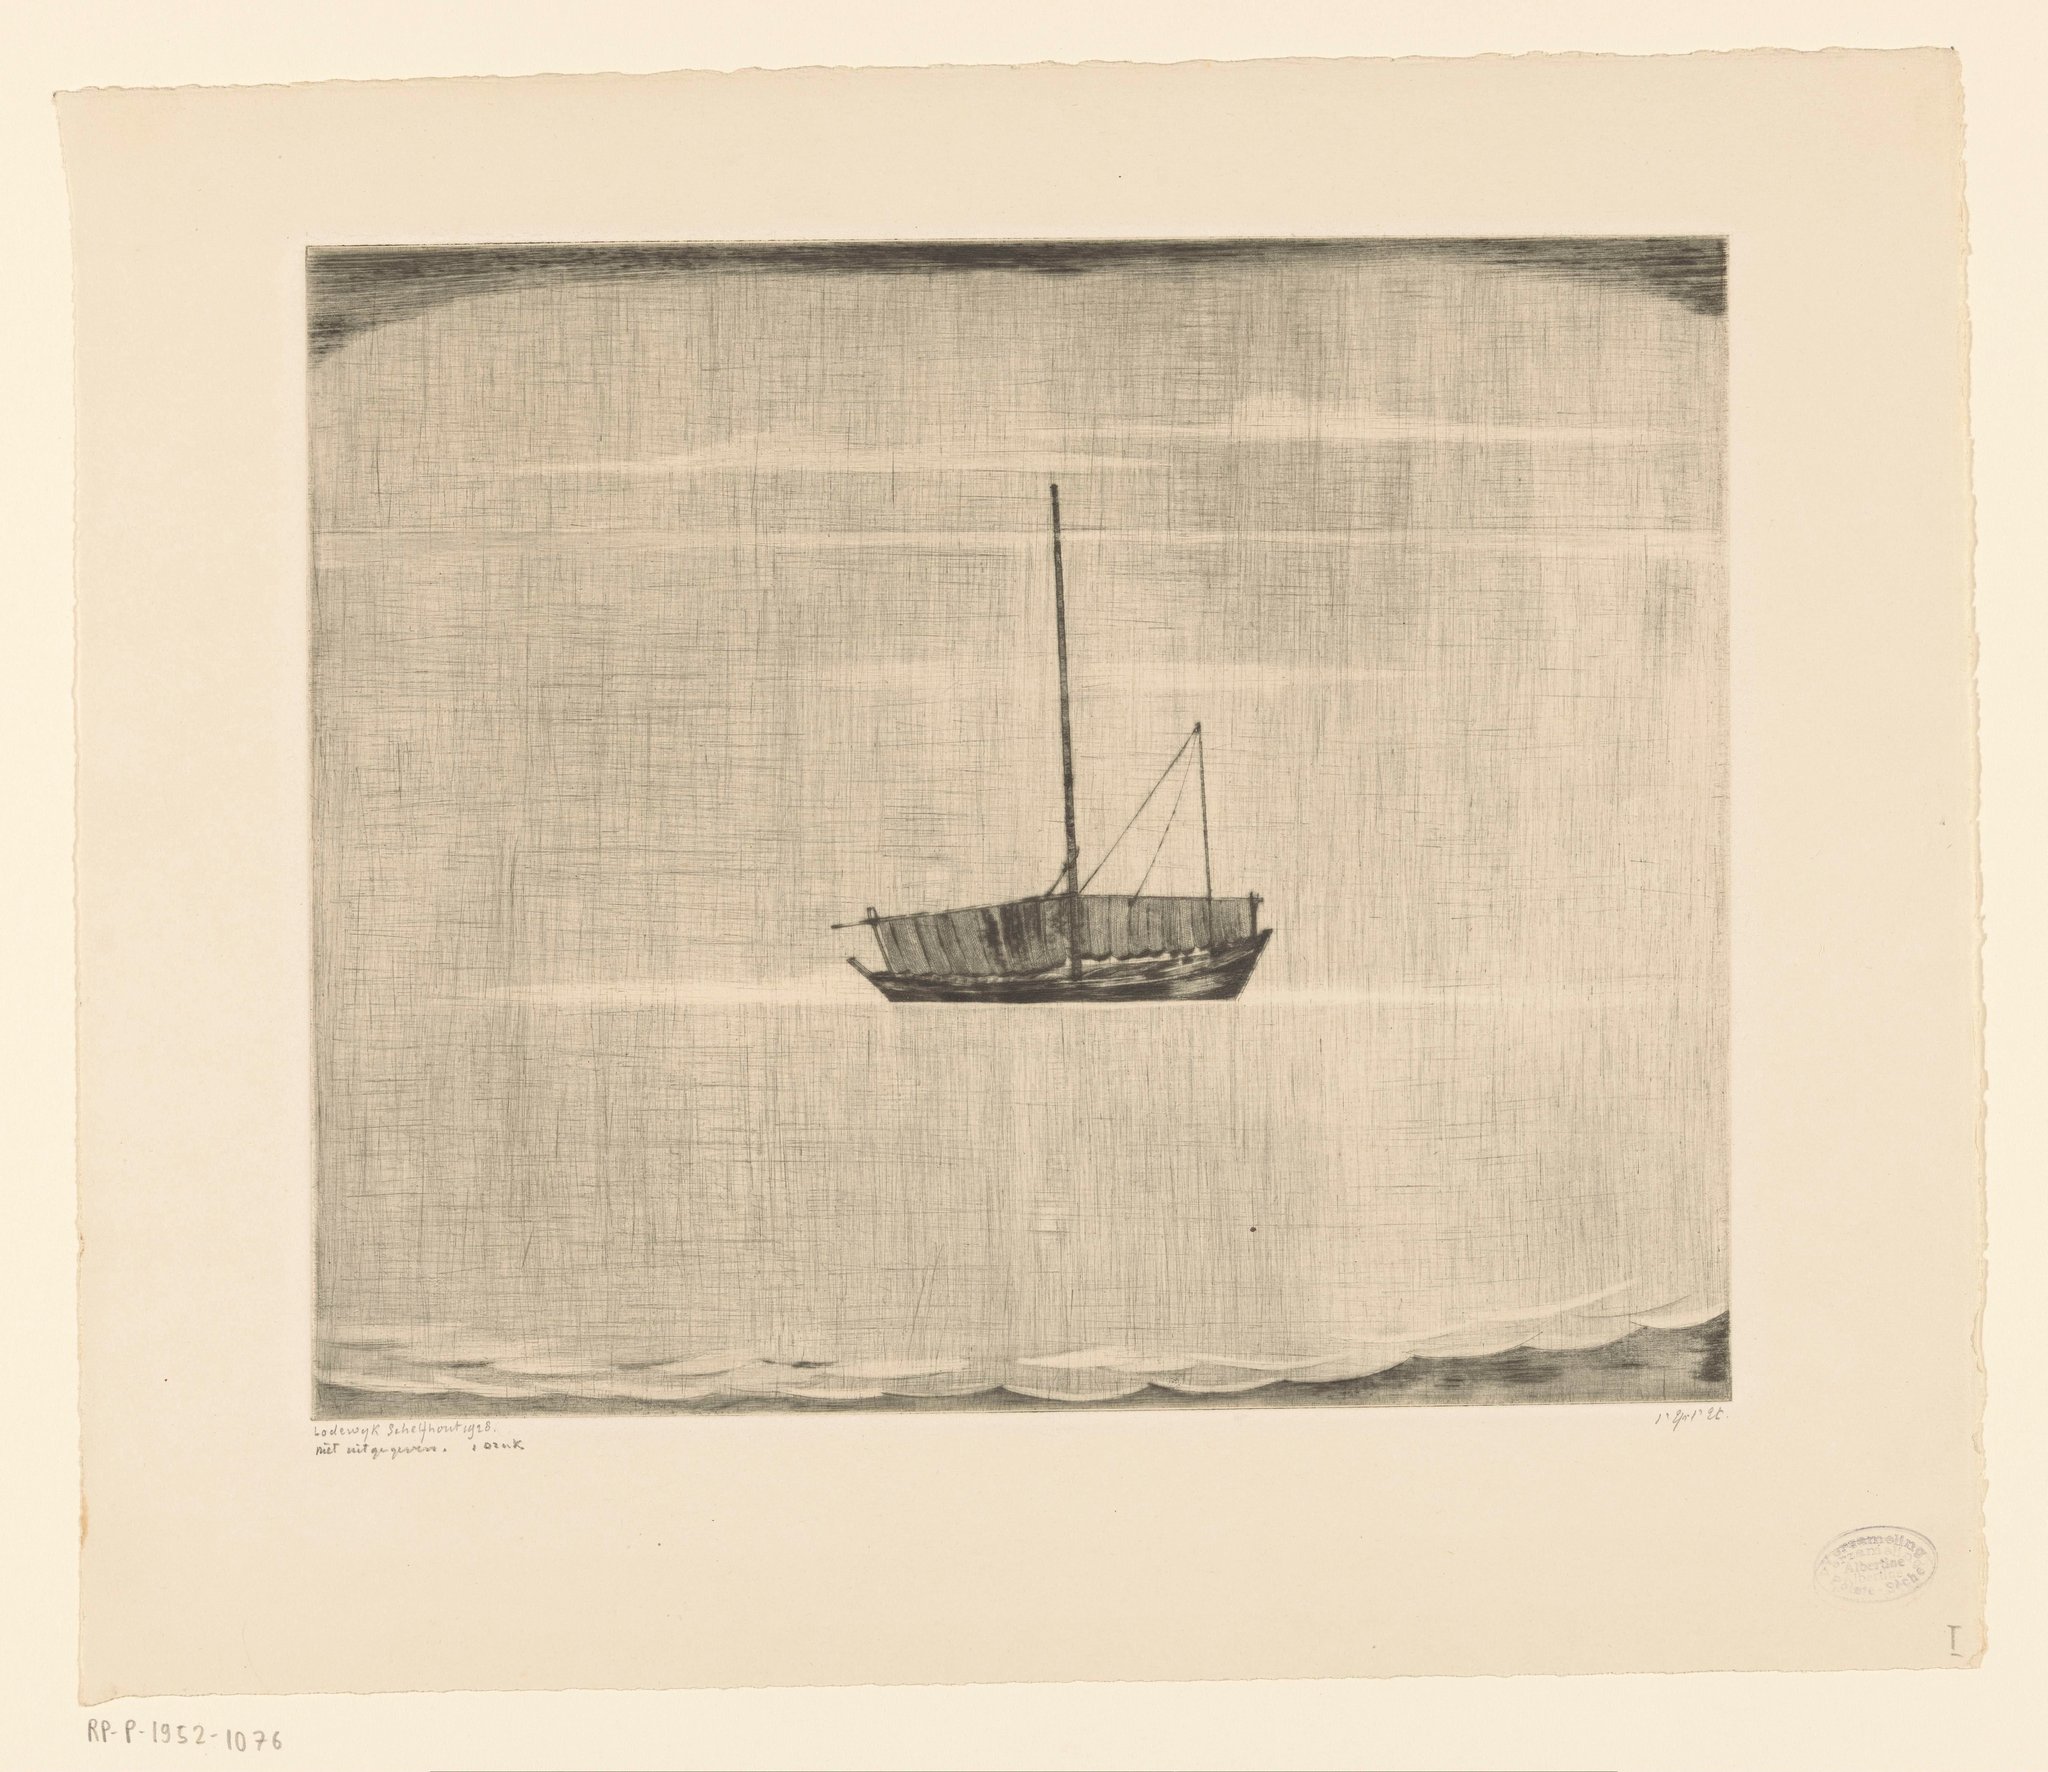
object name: print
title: Dans le brouillard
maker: lodewijk schelfhout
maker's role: draughtsman, print maker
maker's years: 1881-1943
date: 1928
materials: paper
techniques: drypoint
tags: ships (in general), mist, fog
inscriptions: collector's mark: Lugt 2228, inscription: ‘niet uitgegeven’, collector's mark: Lugt 5i